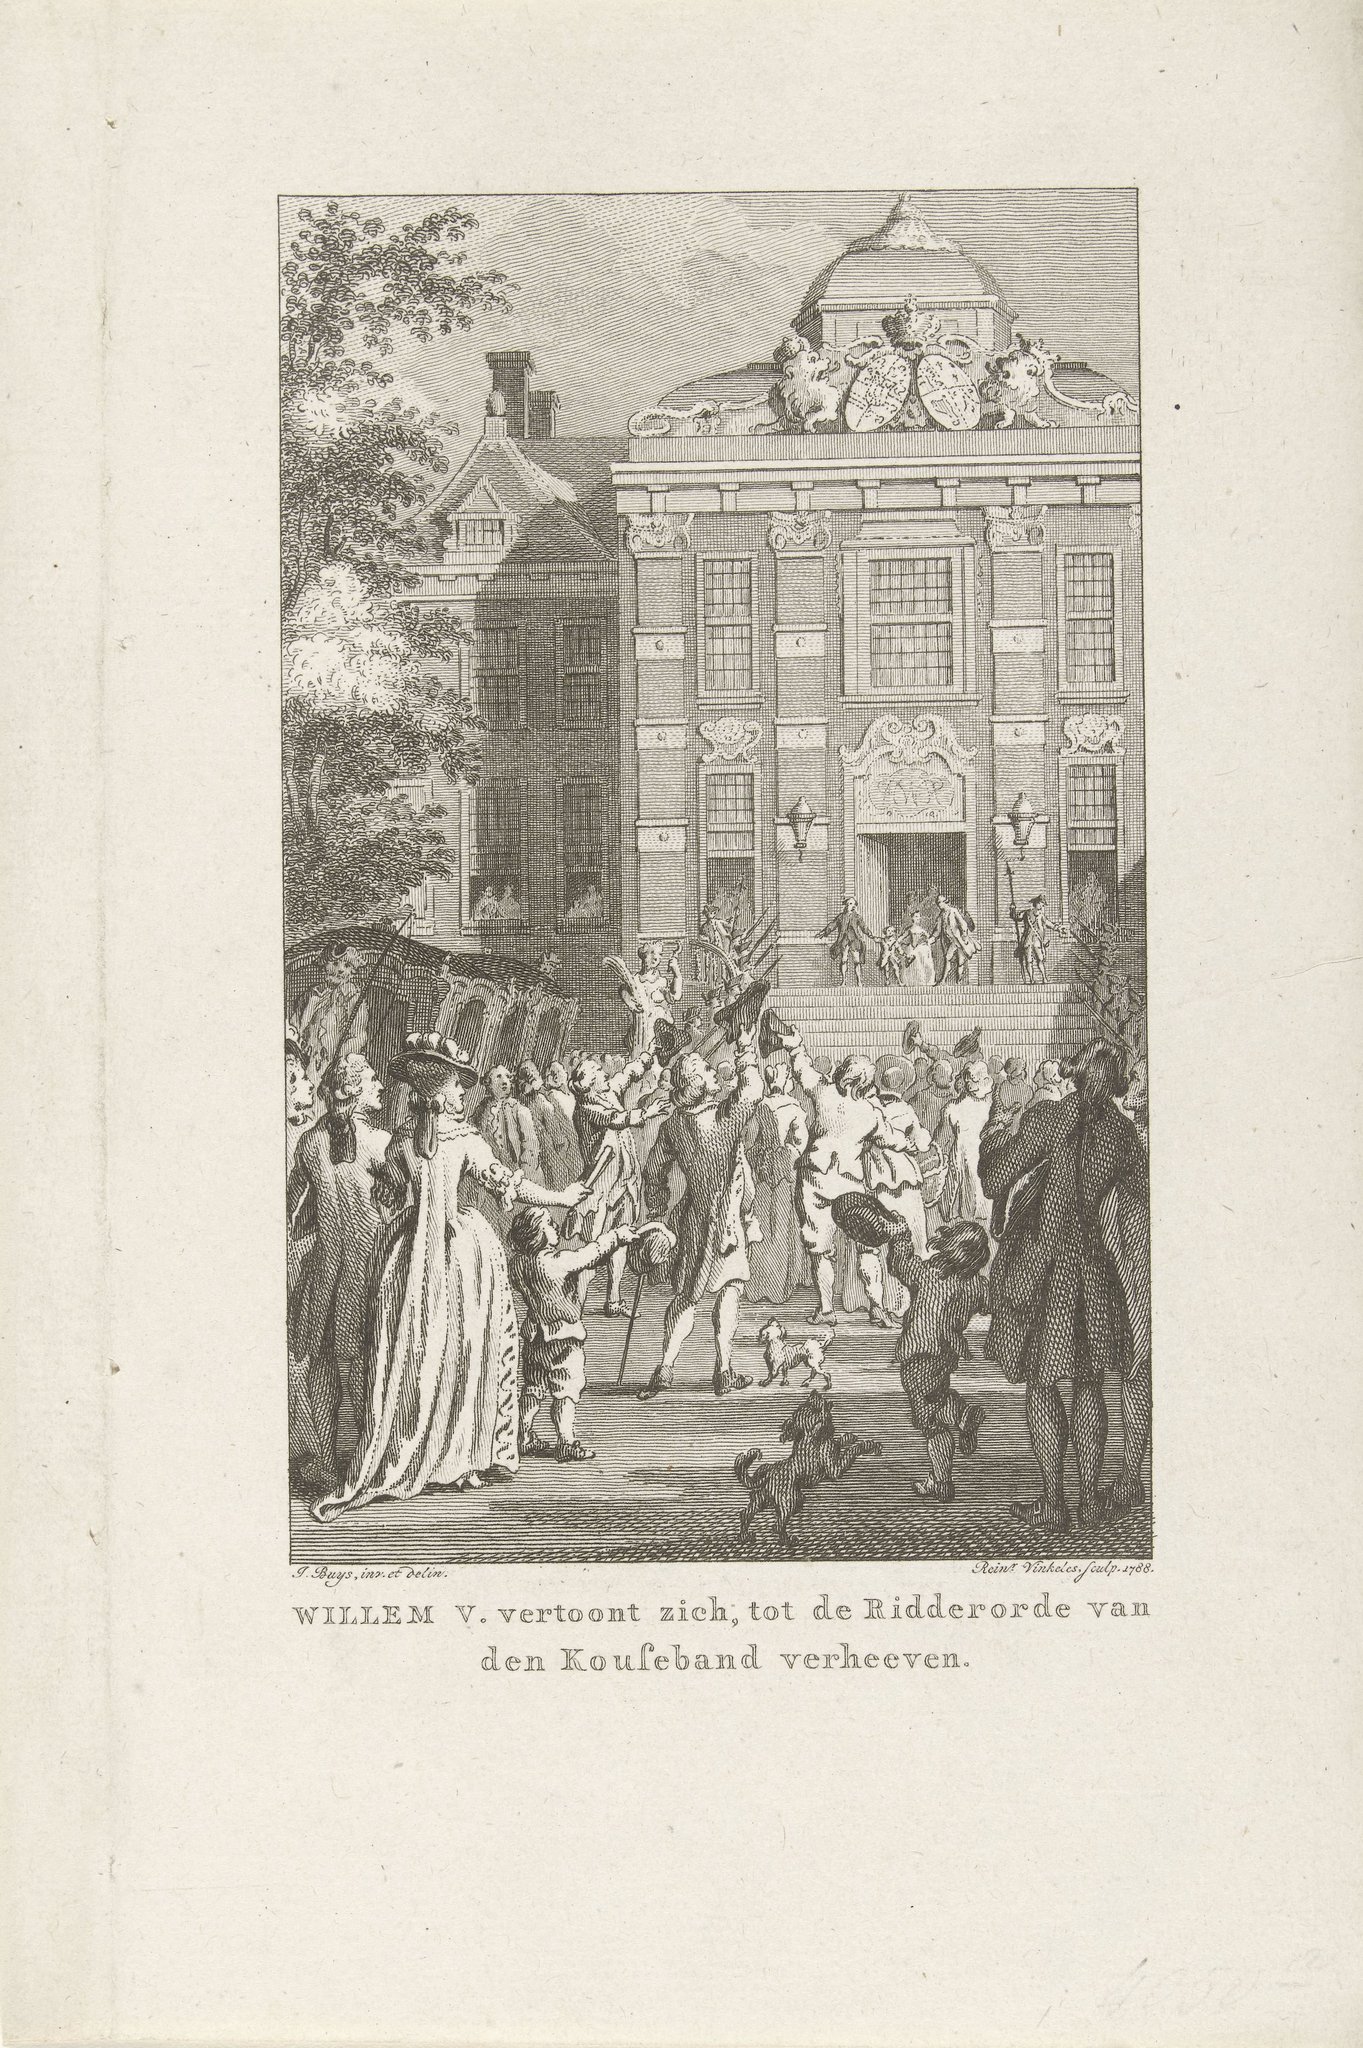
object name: print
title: Willem V vertoont zich als Ridder in de Orde van de Kousenband op het bordes van Huis ten Bosch, 1752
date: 1788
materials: paper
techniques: etching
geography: northern netherlands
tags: the hague, william v (prince of orange), knighthood order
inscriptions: collector's mark: Lugt 2228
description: Gebruikt als illustratie in: P.A. Loosjes, Vaderlandsche historie, vervattende de geschiedenissen der Vereenigde Nederlanden (...).Twee-en-twintigste deel. Beginnende met den jaare 1752 en eindigende met den jaare 1758 ... ten onmiddelyken vervolge van Wagenaar's Vaderlandsche historie.